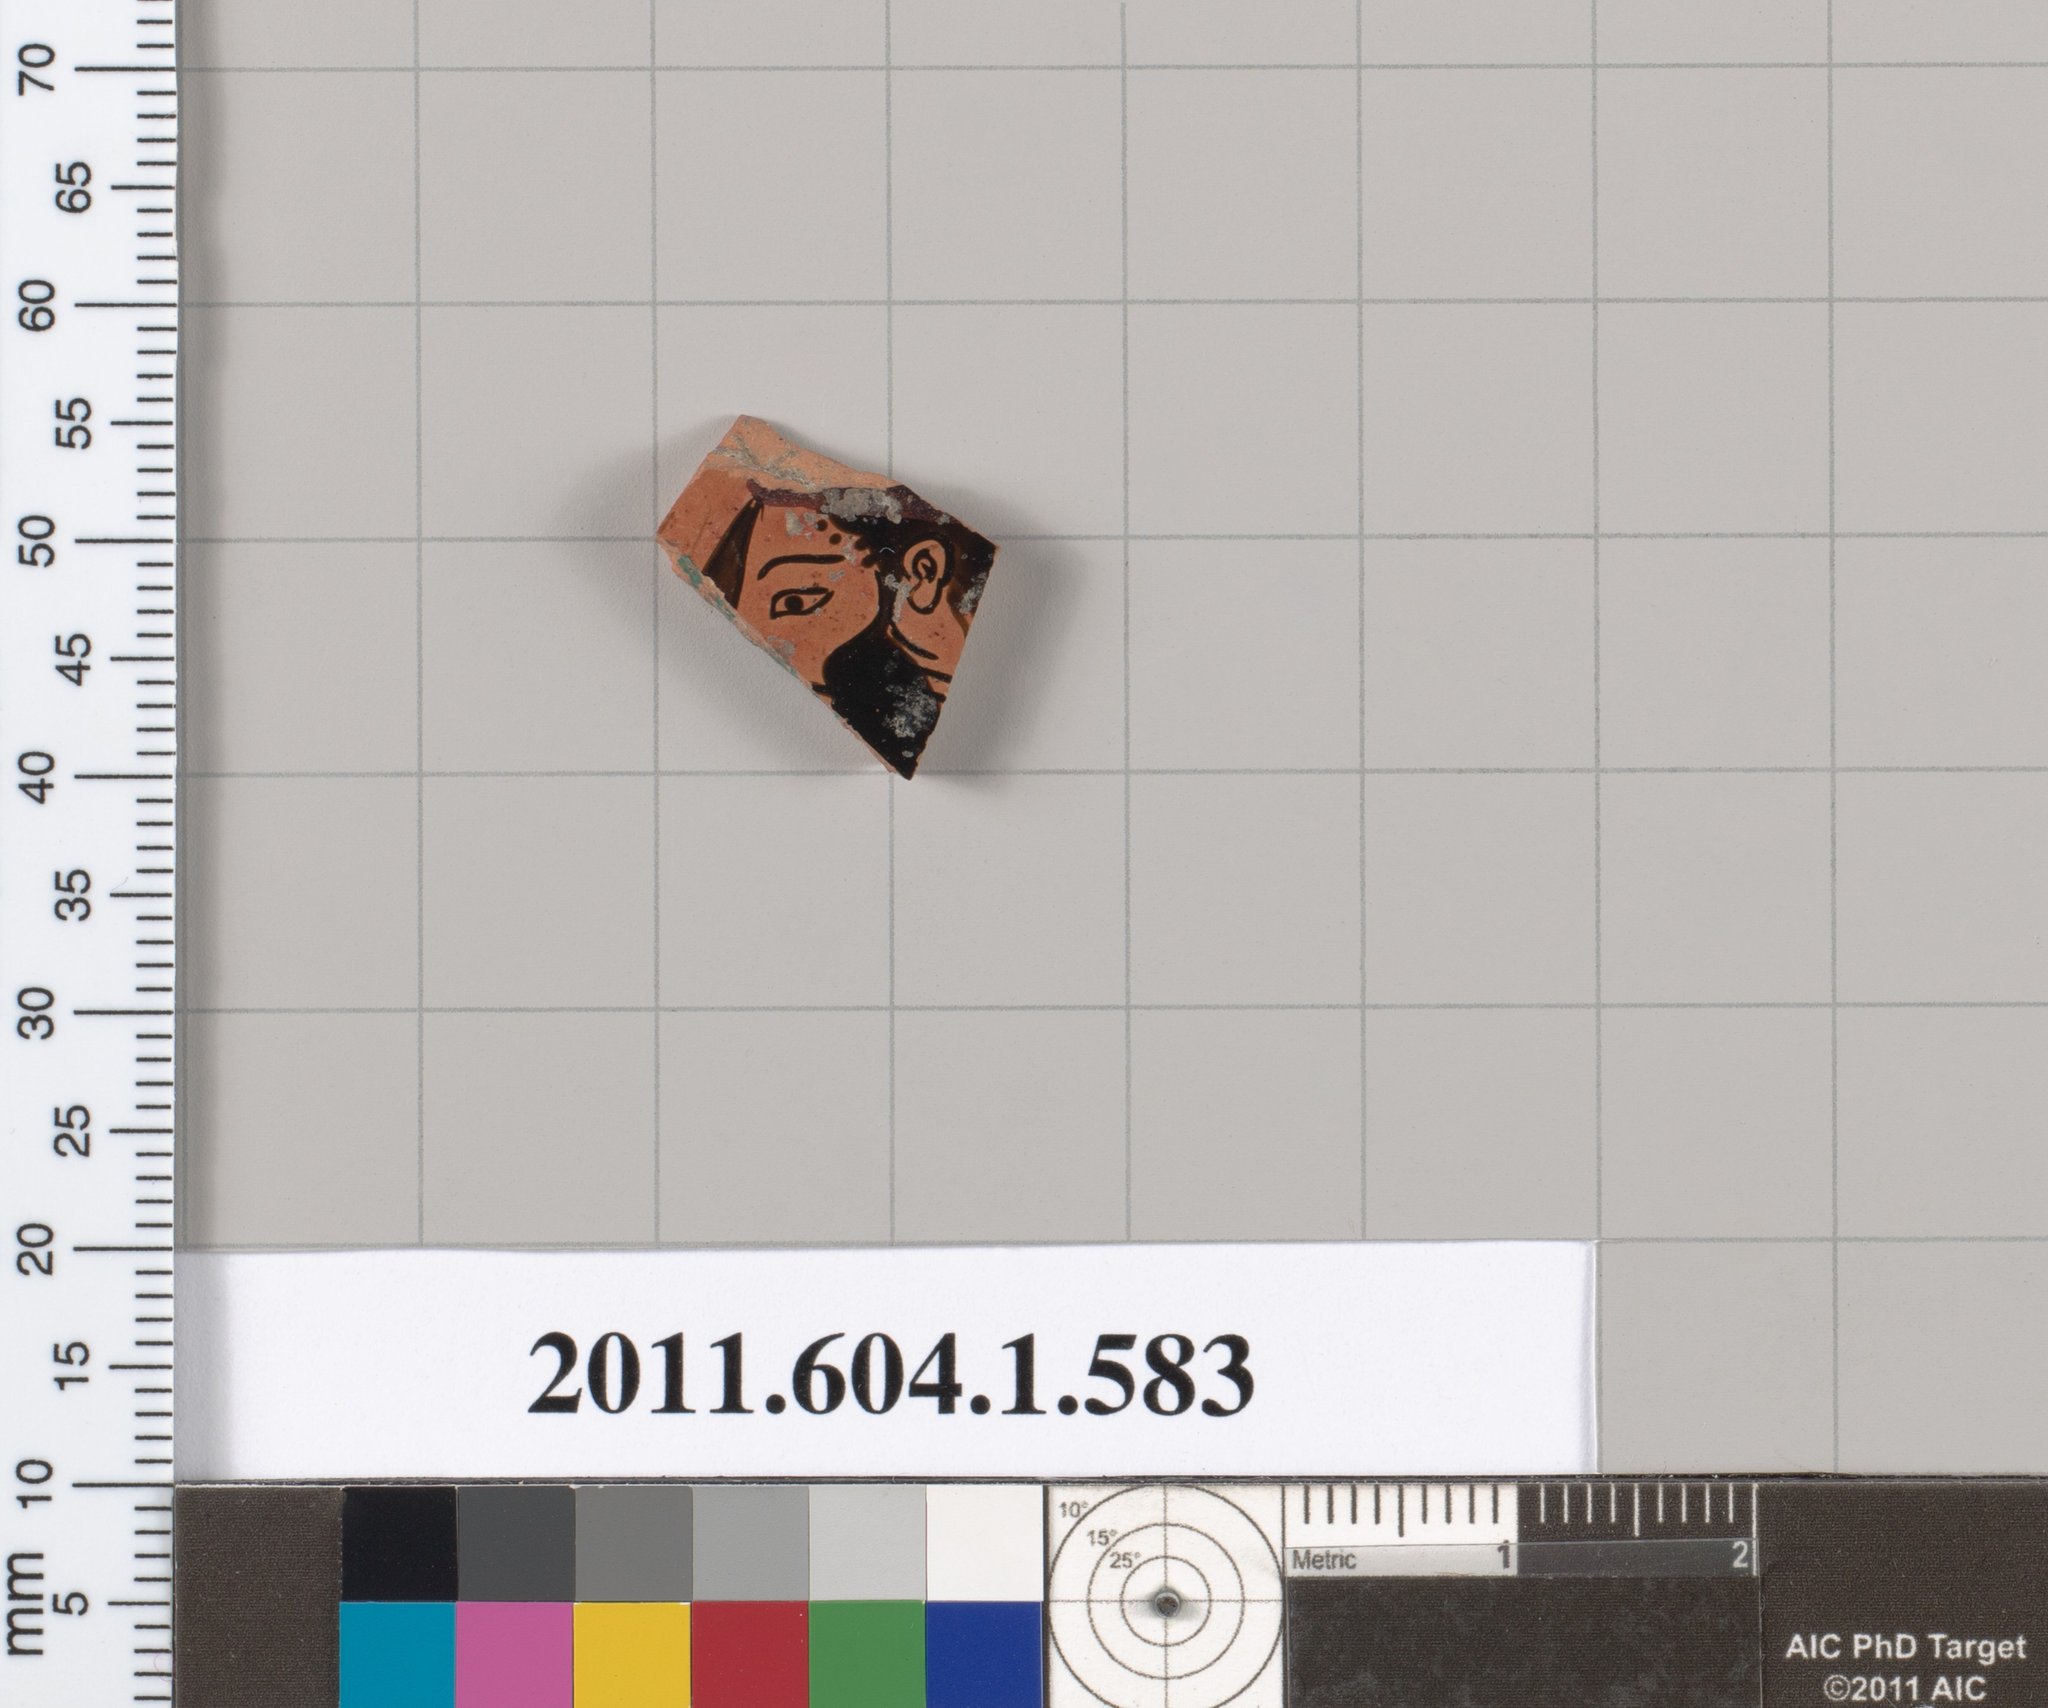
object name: kylix fragment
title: Terracotta fragment of a kylix (drinking cup)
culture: greek, attic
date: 490-480 BCE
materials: terracotta